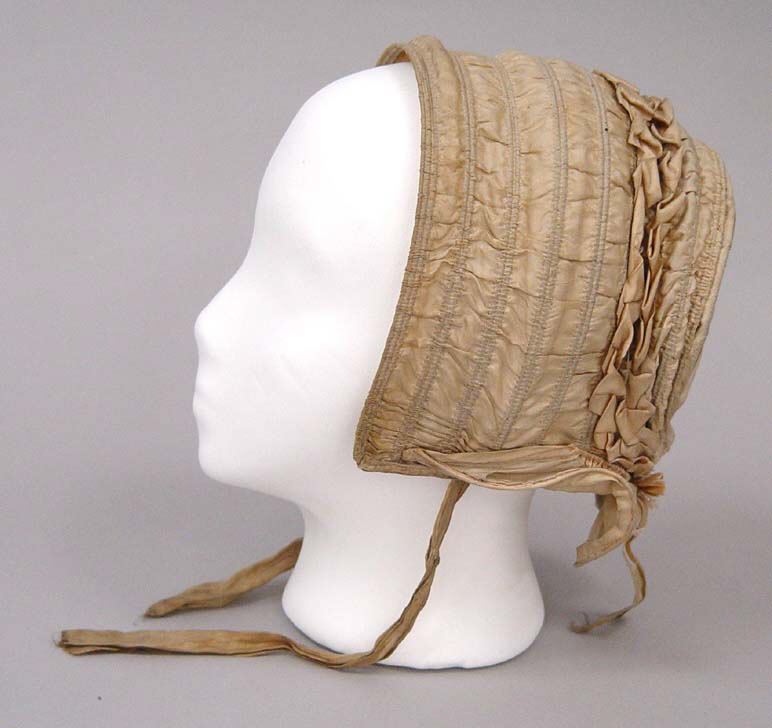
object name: bonnet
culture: european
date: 1840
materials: silk